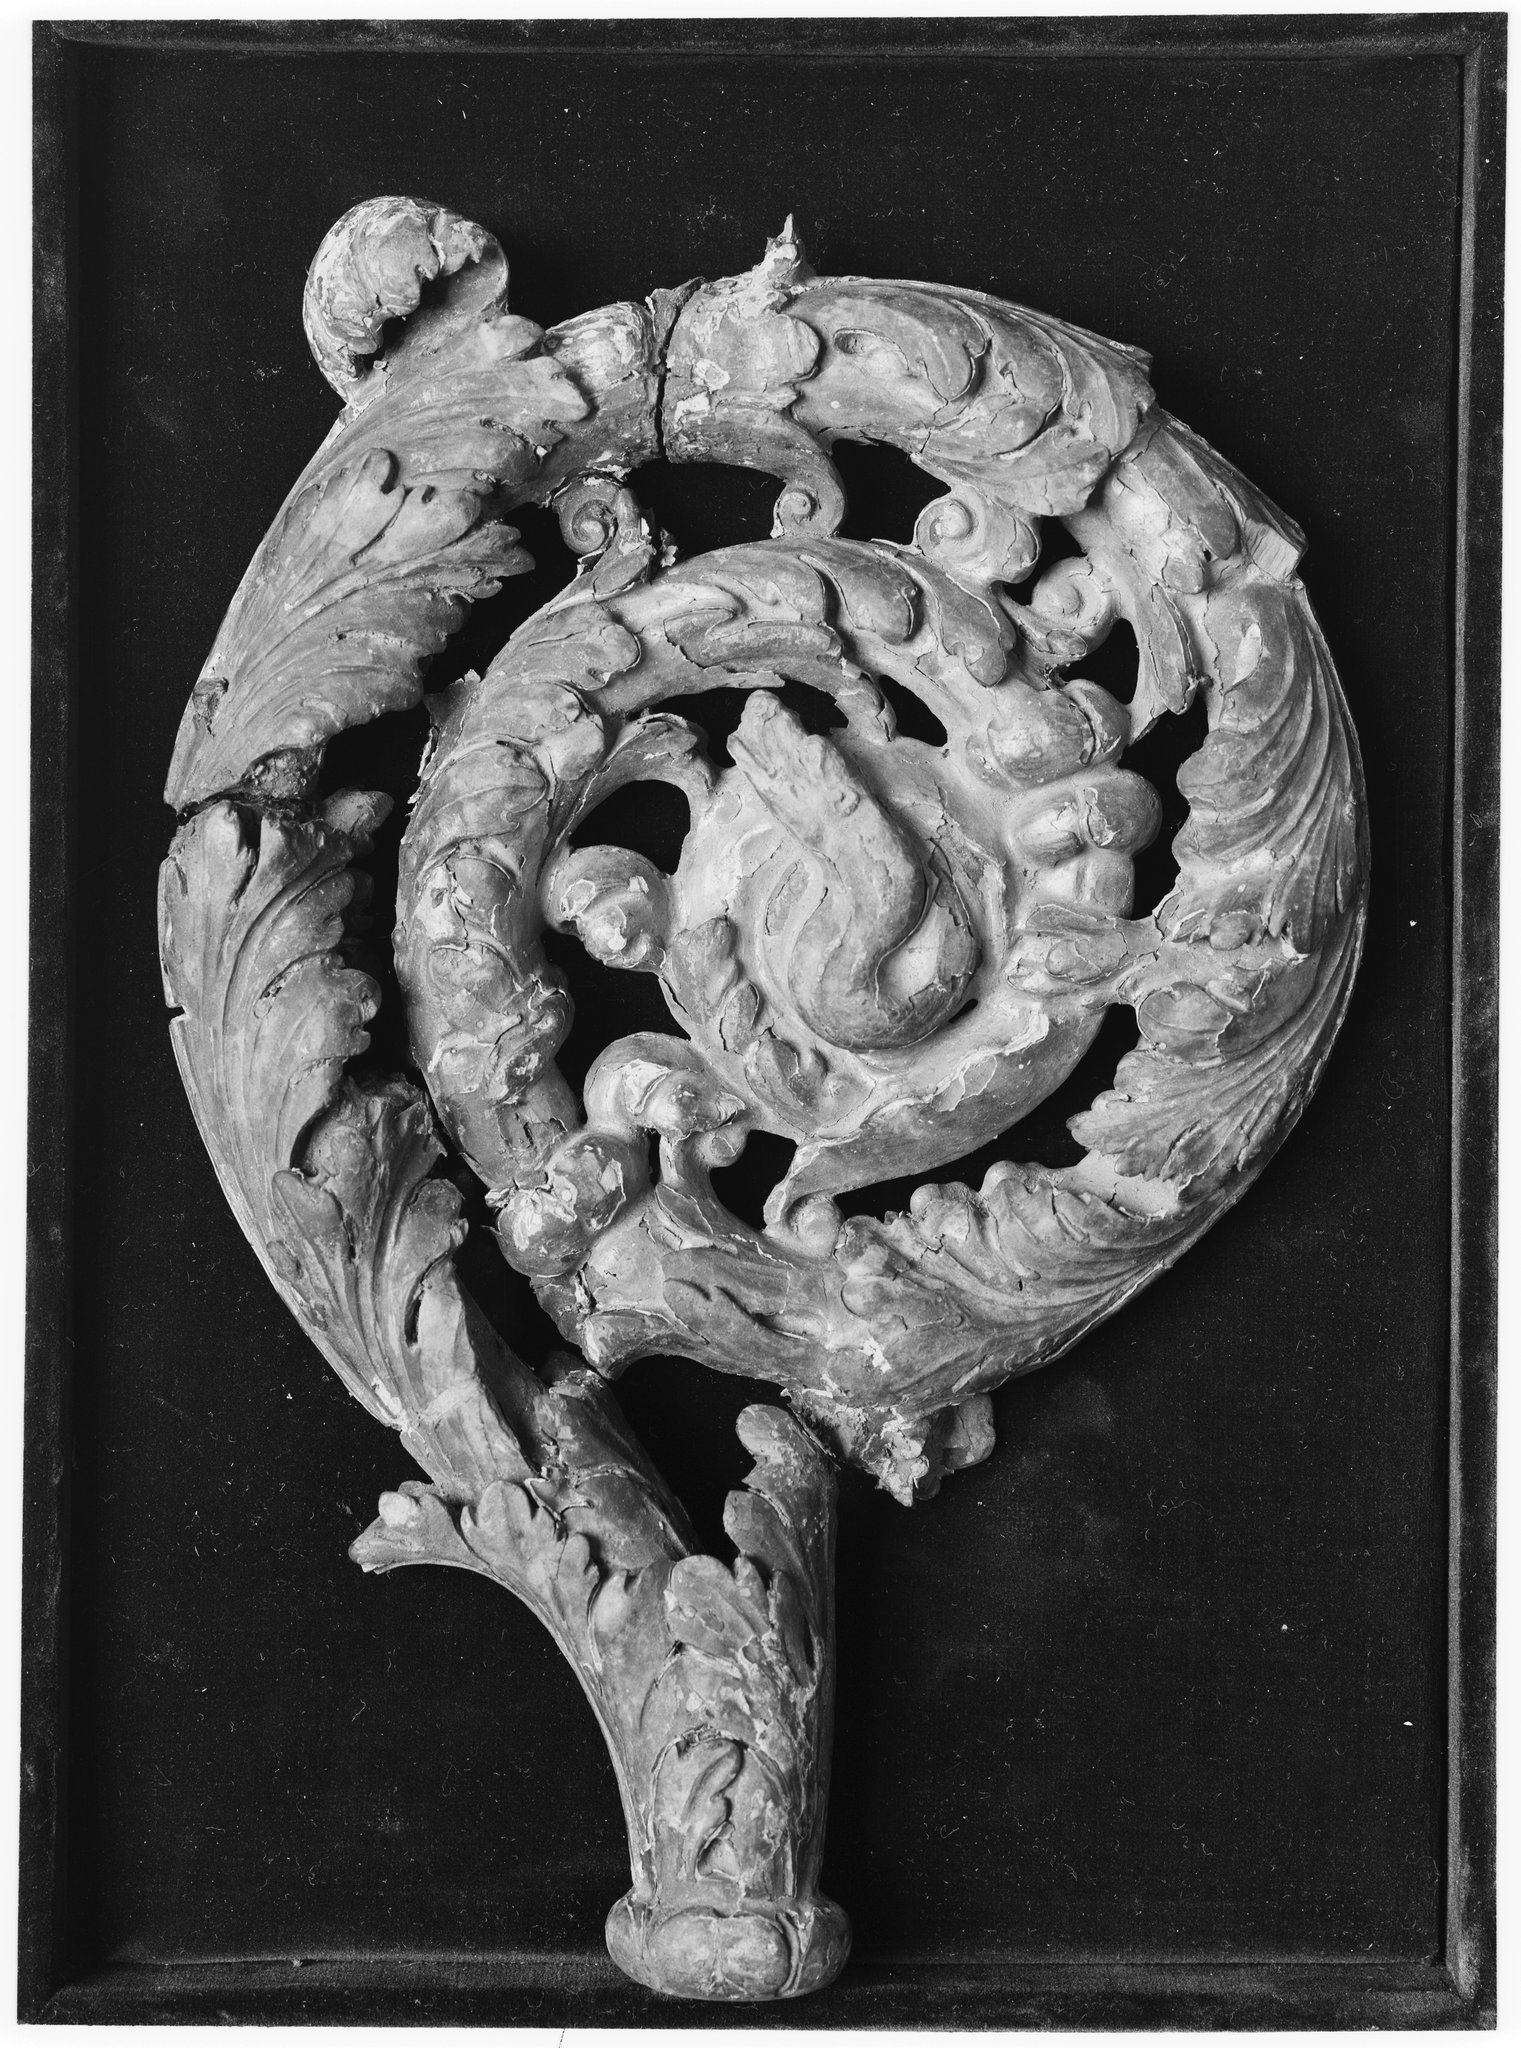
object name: crozier head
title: Head of a crozier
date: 1601-1700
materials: wood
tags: croziers